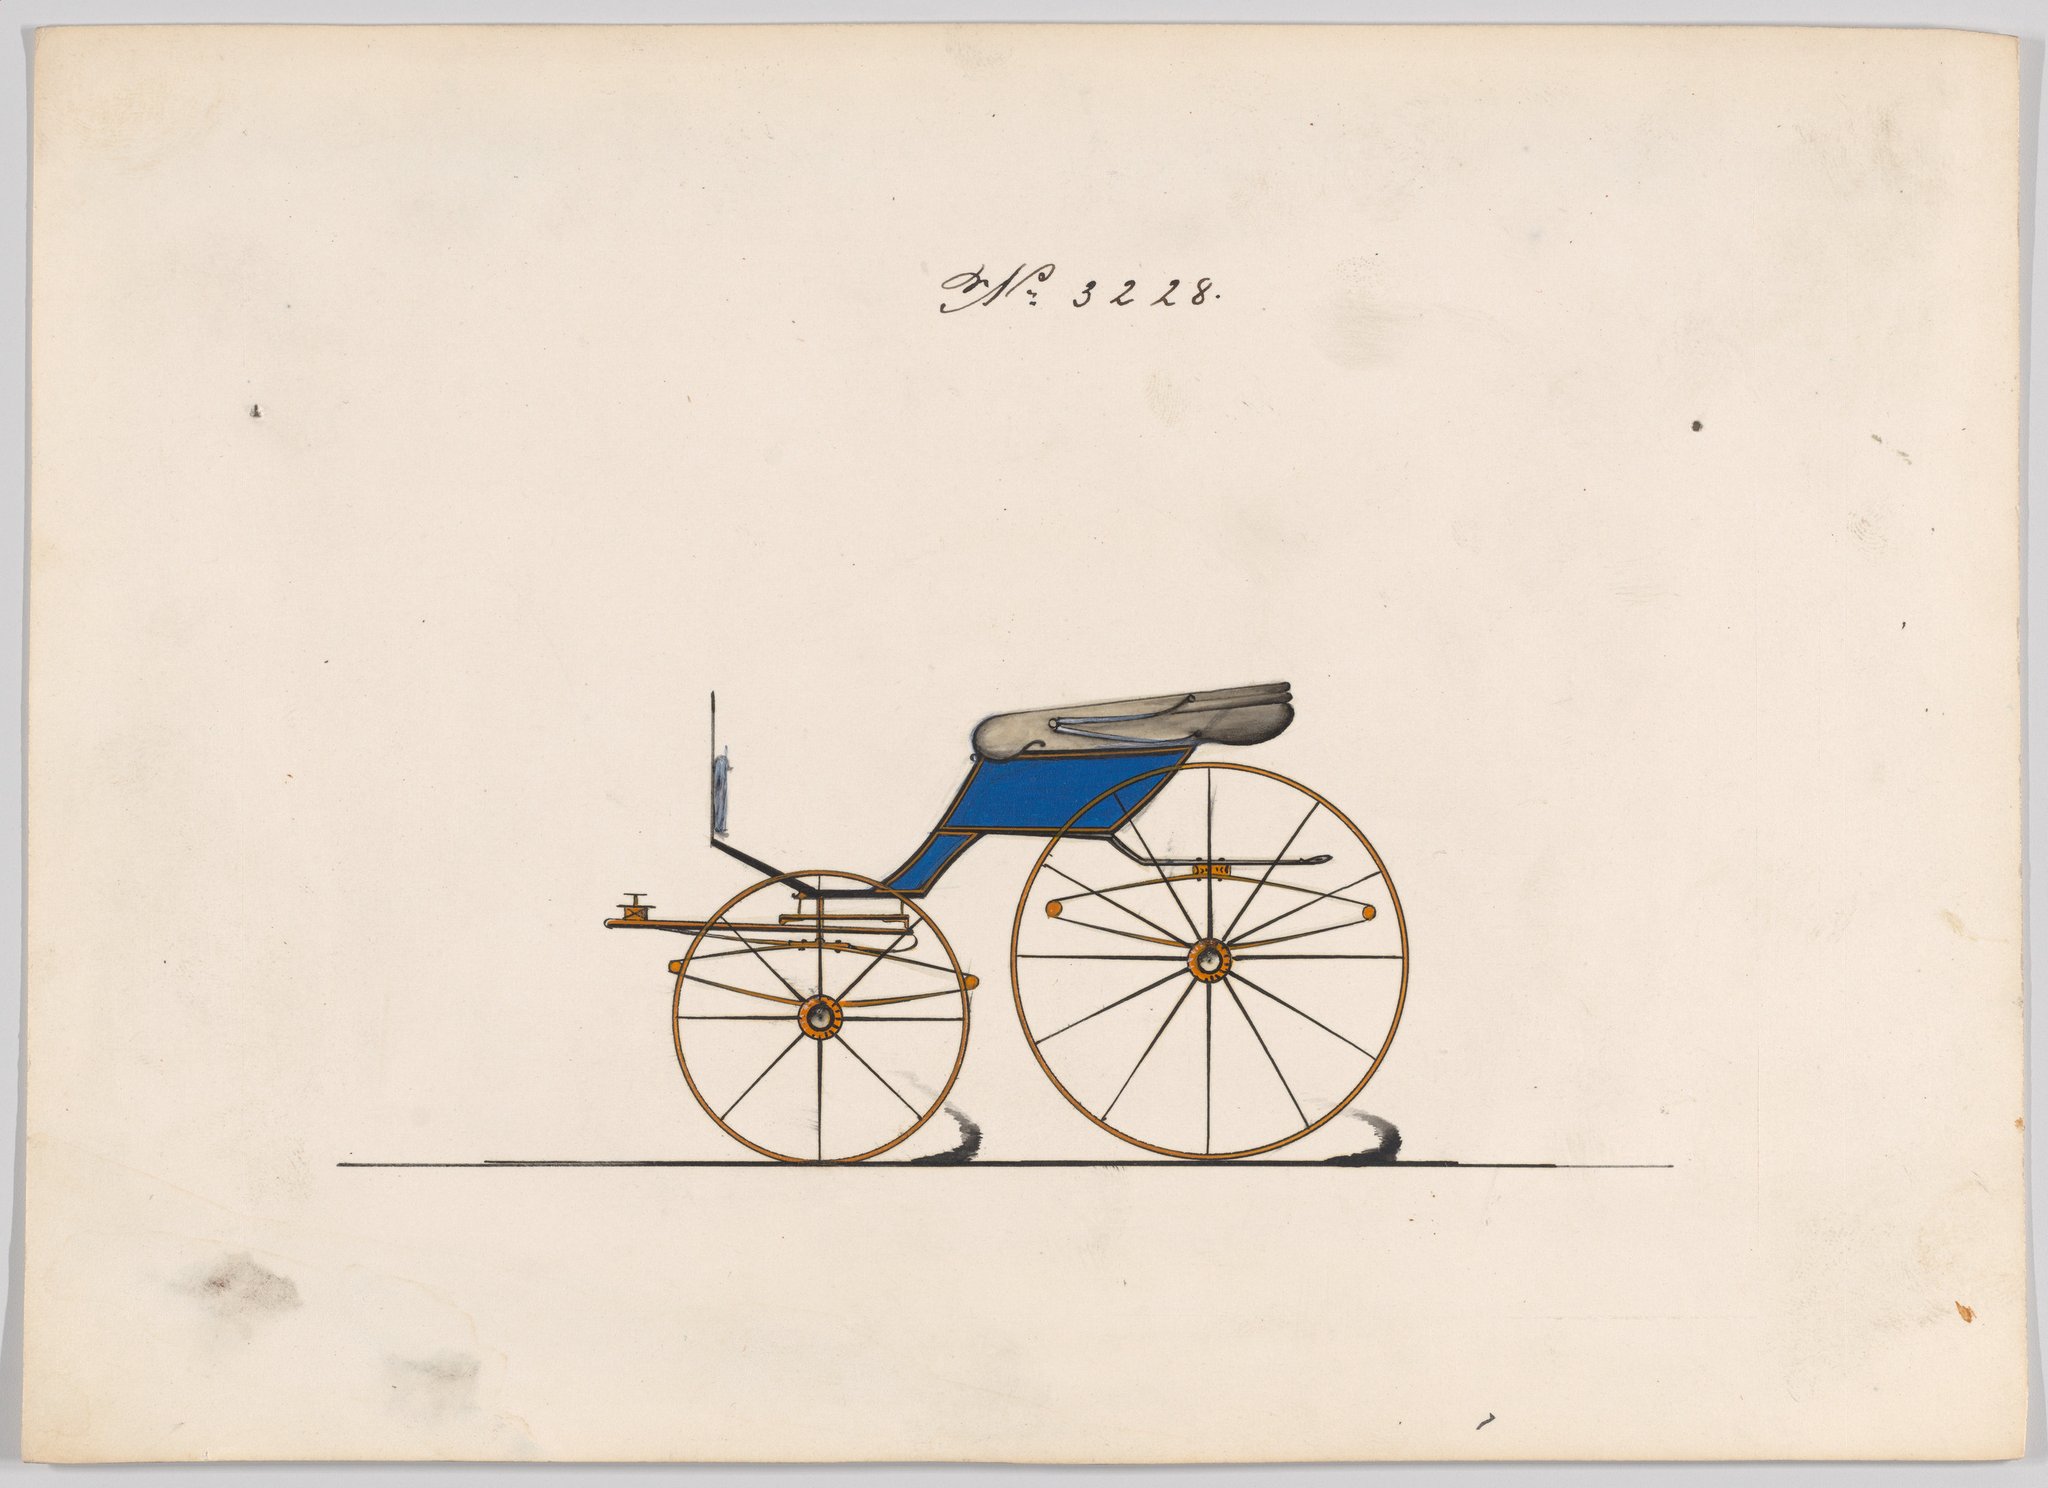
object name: drawing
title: Design for Pony Phaeton, no. 3228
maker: brewster & co.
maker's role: manufacturer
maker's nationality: american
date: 1876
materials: gouache, gum arabic, ink, watercolor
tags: carriages